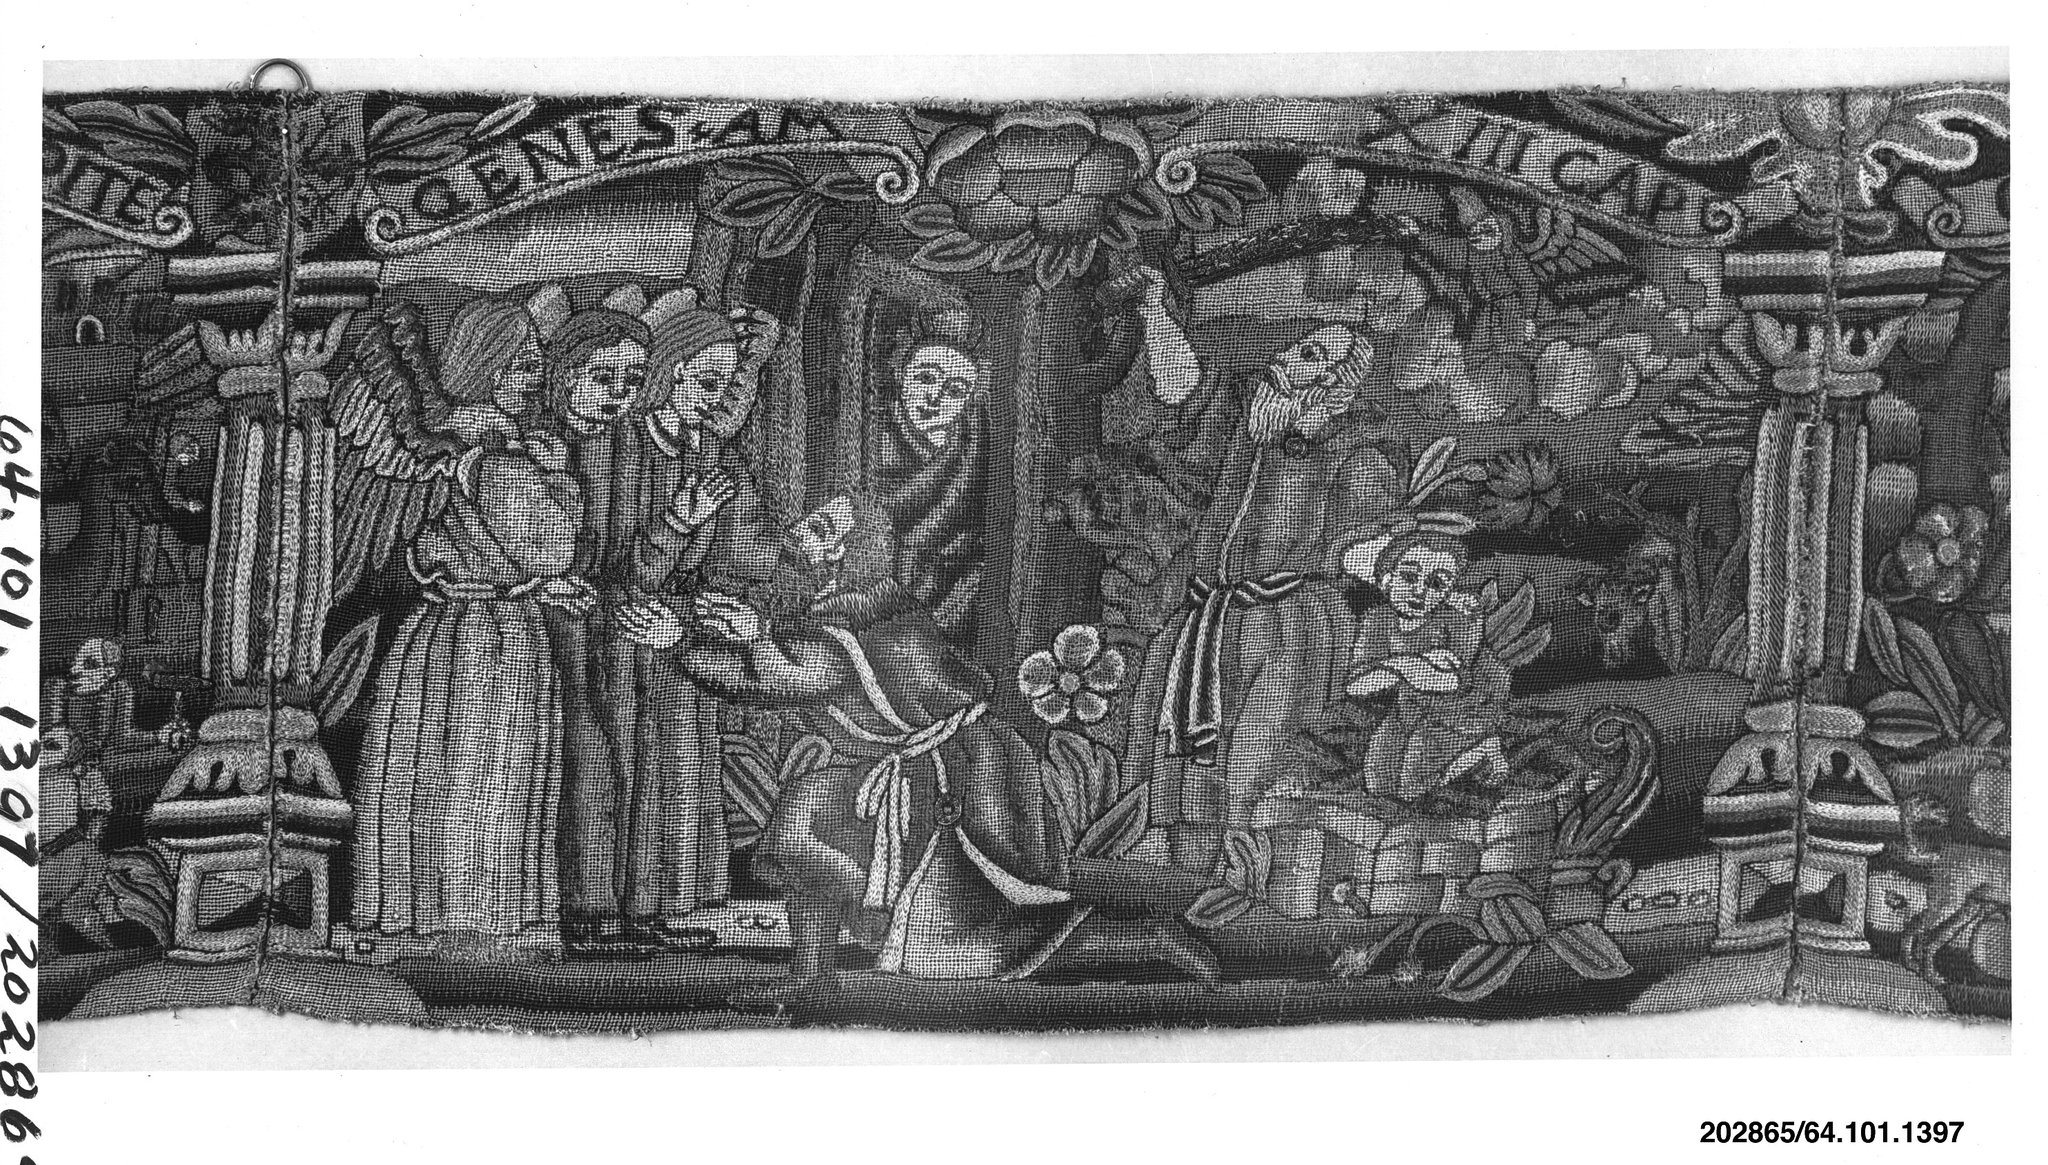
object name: valance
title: Needlepoint valance (one of three)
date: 1604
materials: canvas, metal thread, silk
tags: men,women,flowers